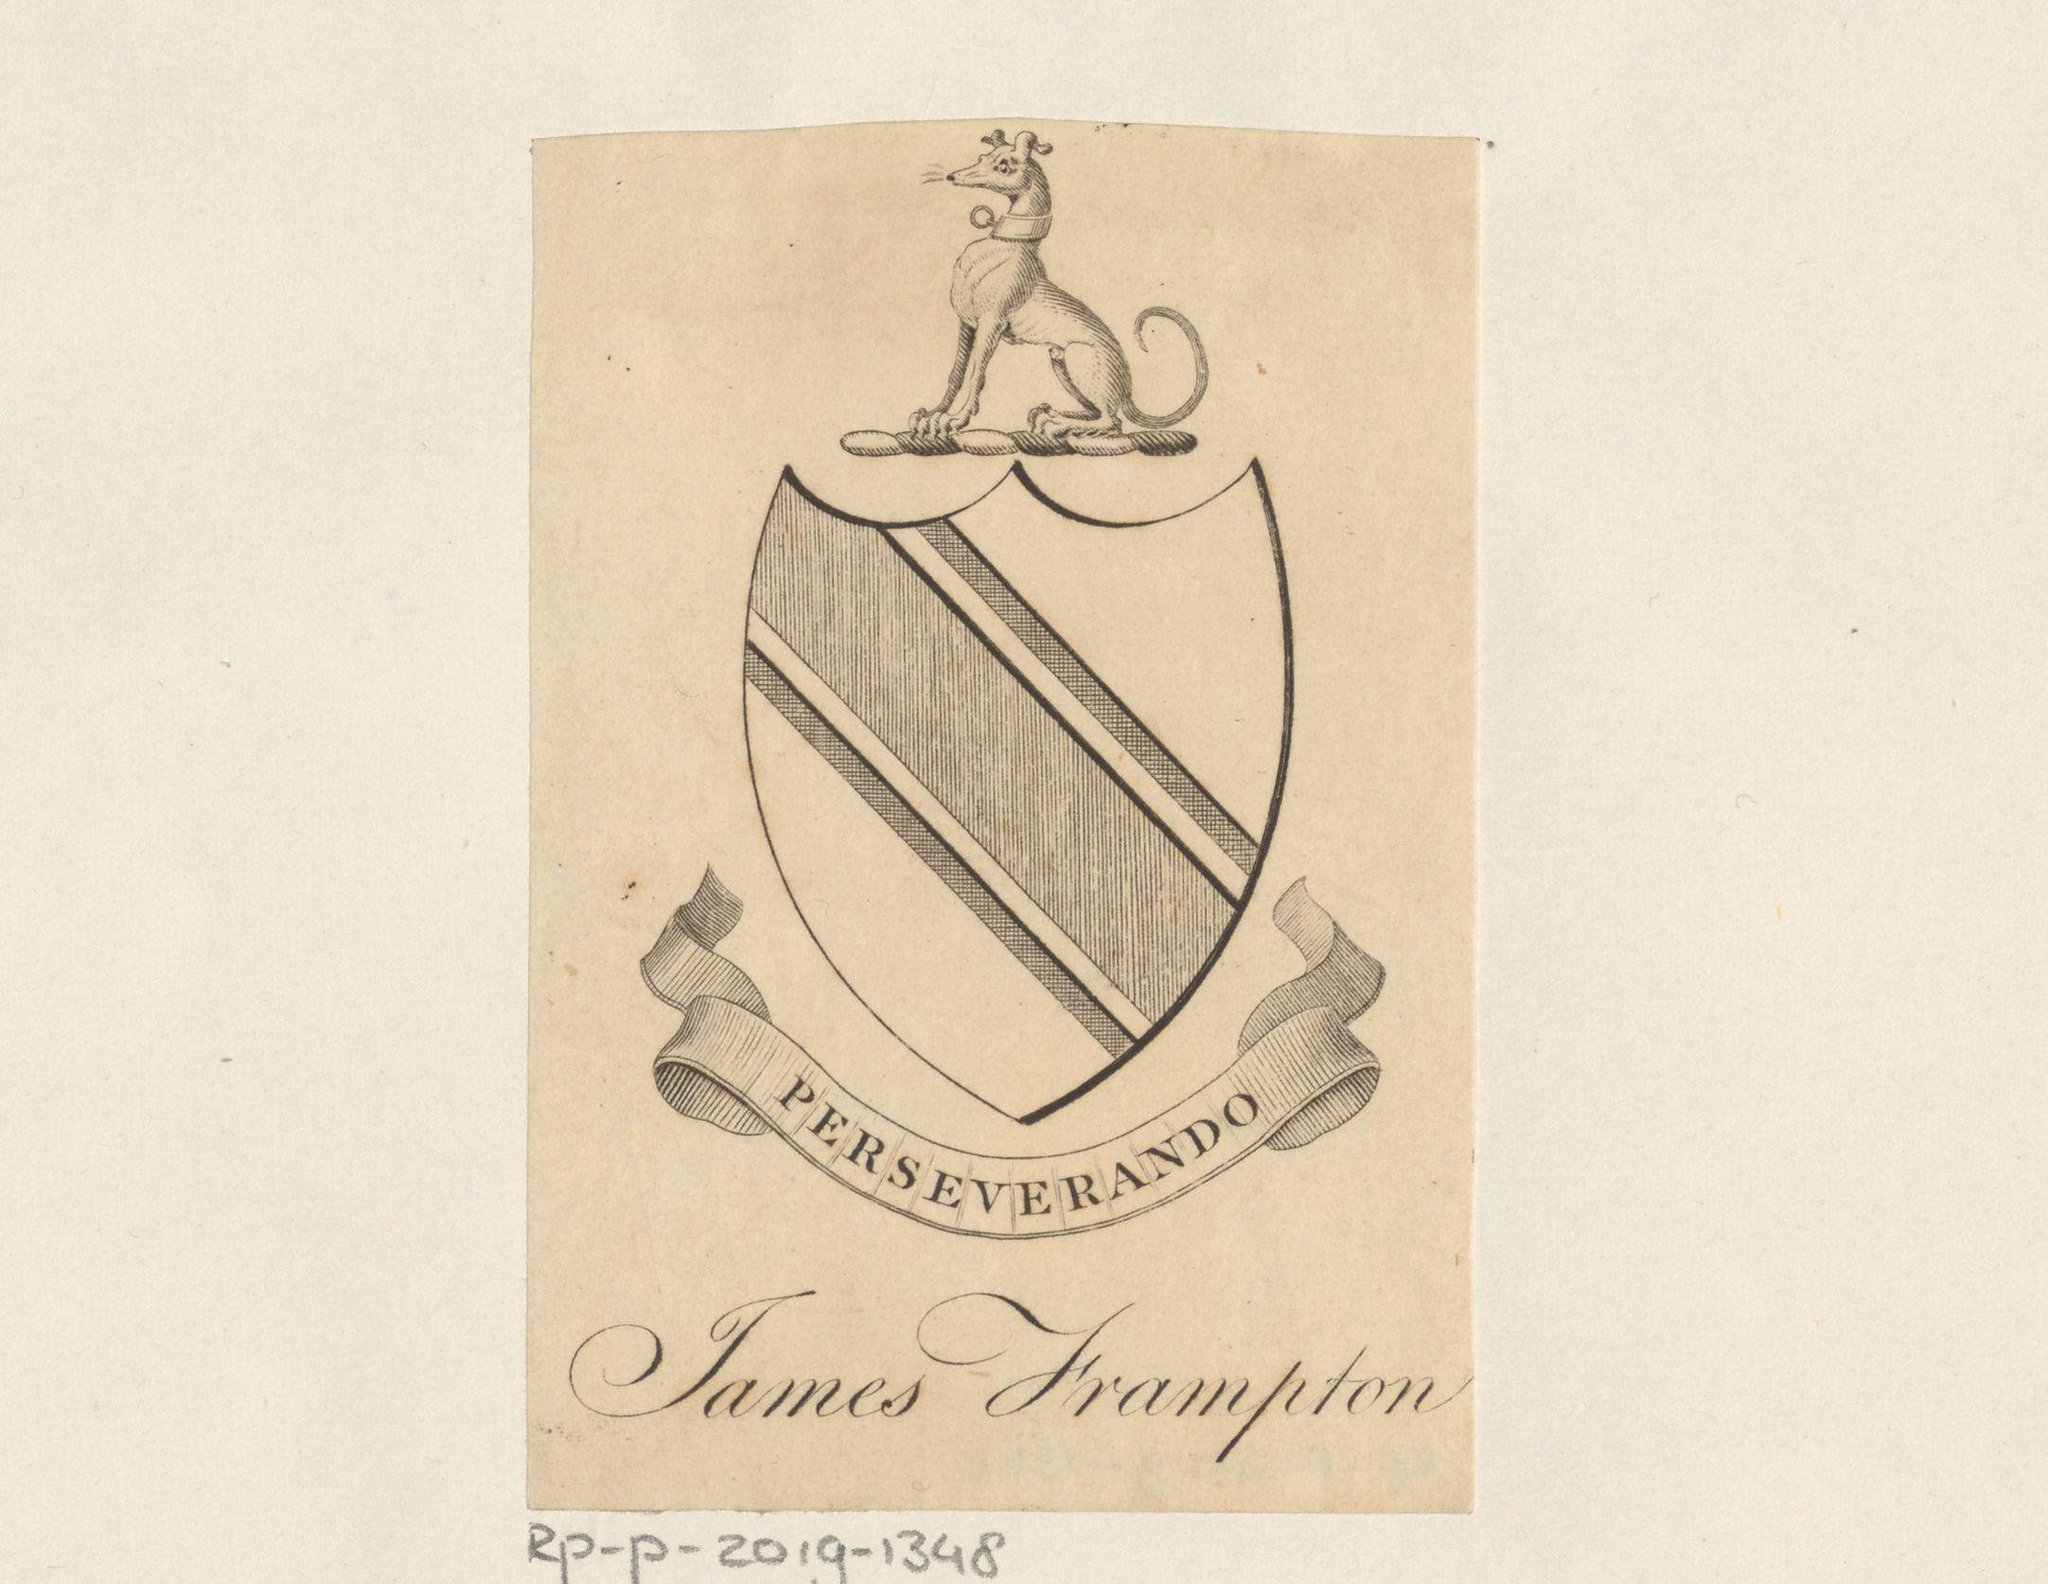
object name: bookplate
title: Perseverando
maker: Anonymous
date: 1750-1849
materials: paper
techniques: engraving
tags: armorial bearing, heraldry